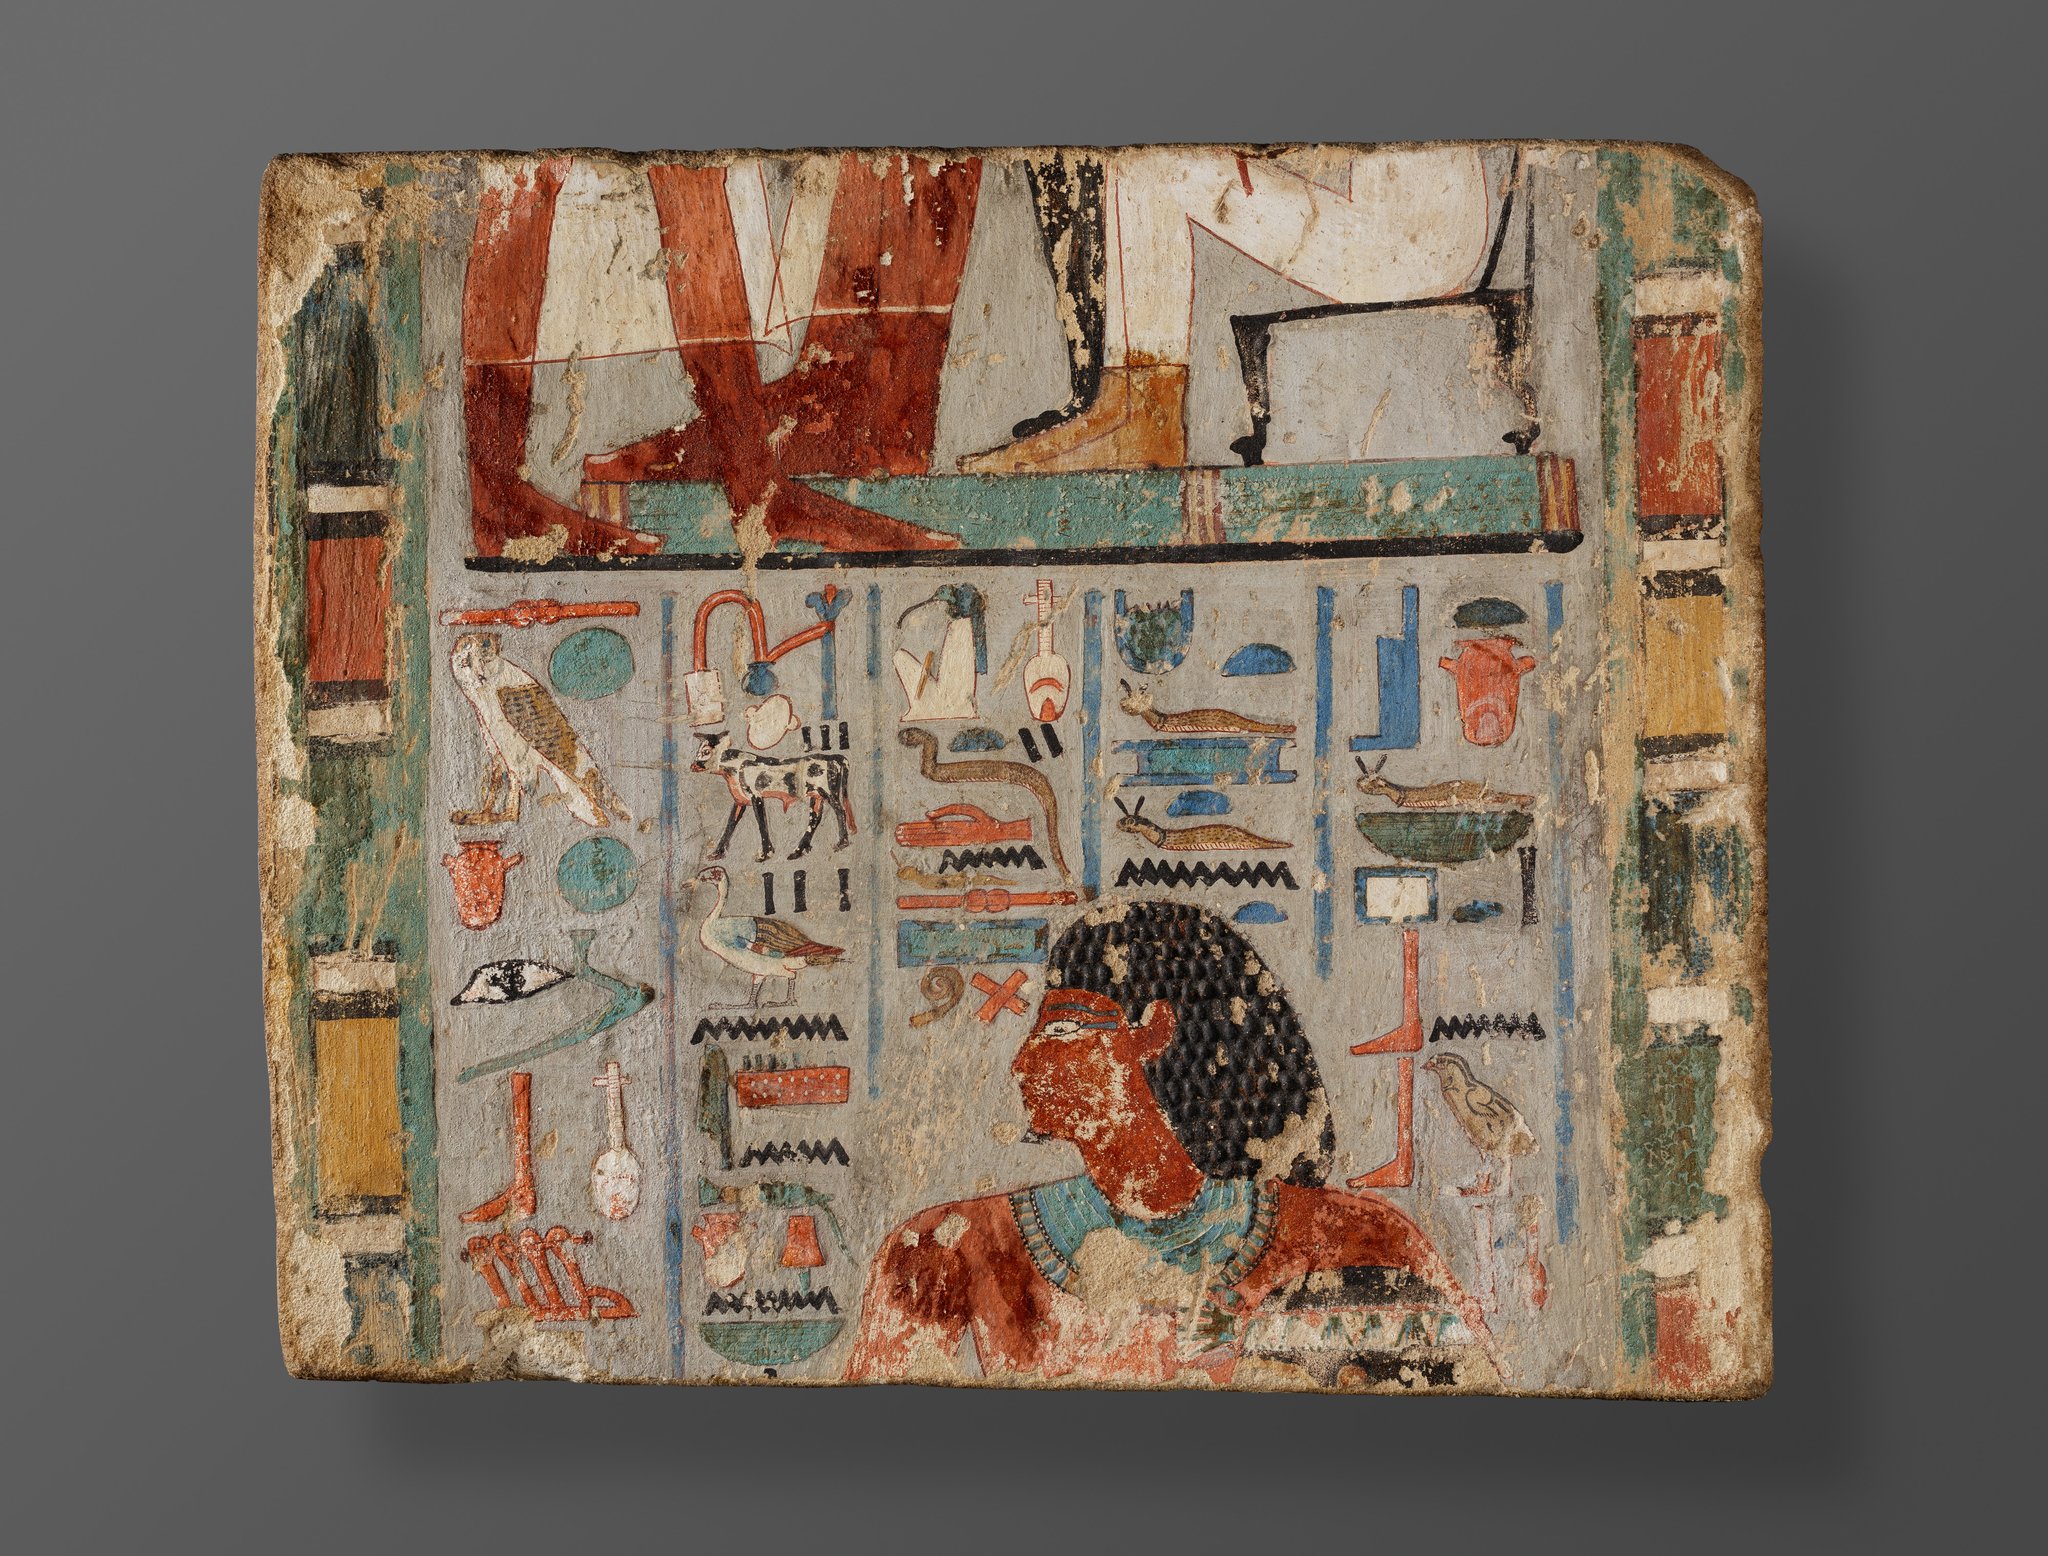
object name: door jamb, painting, djehutynefer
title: Fragment of a Doorjamb from the Tomb of Djehutynefer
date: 1450-1390 BCE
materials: paint, stone